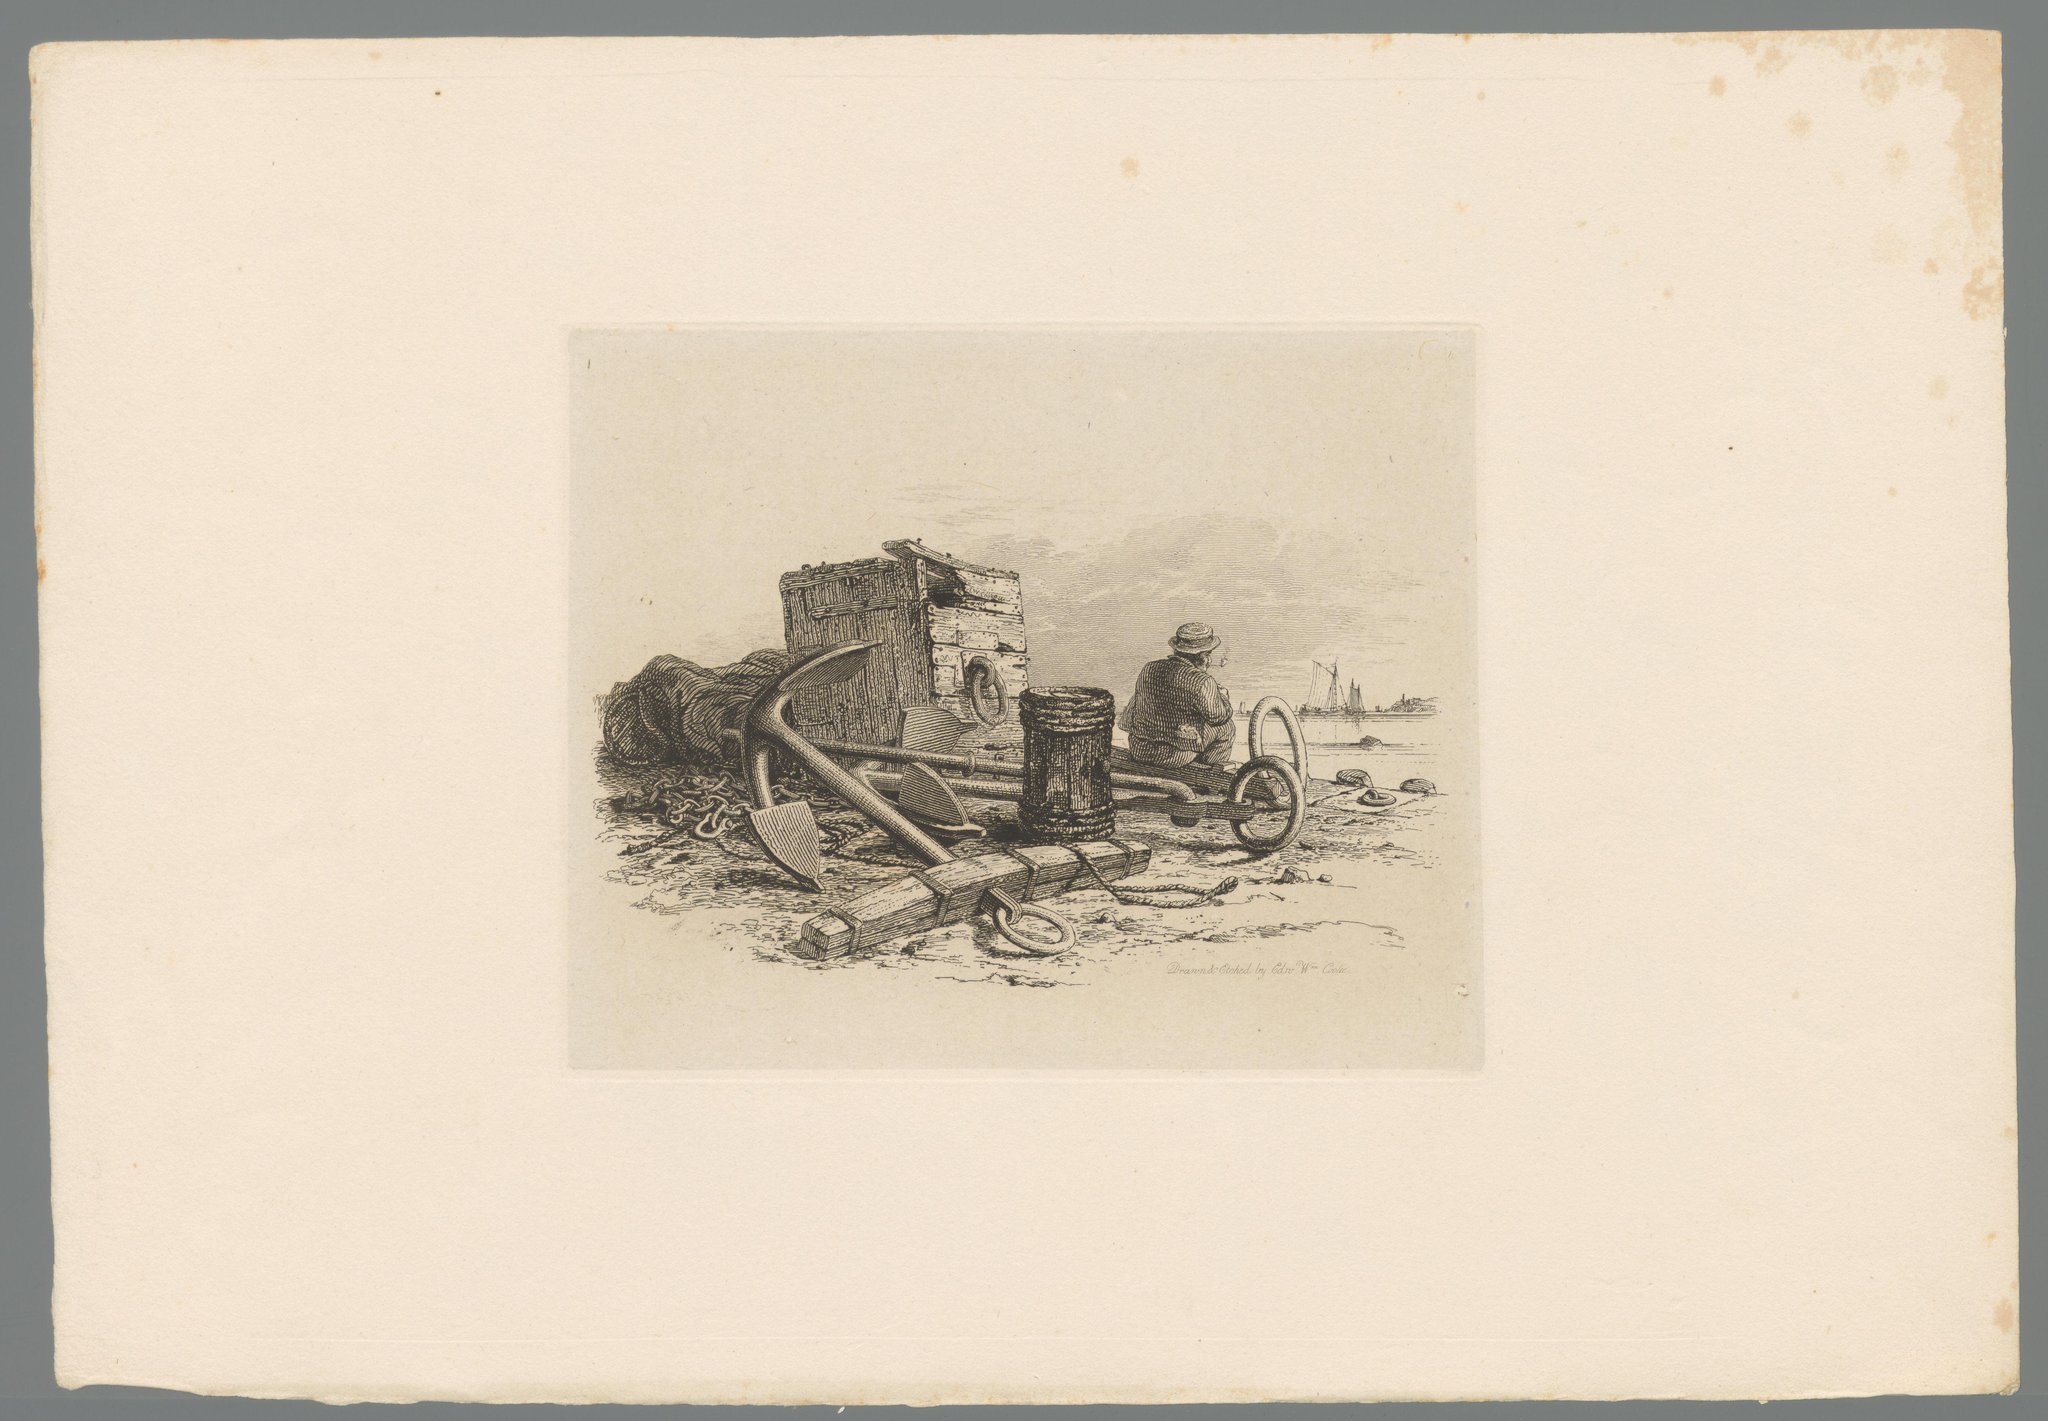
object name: print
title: Anchors & c.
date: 1828-1829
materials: paper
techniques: etching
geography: england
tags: sailing-ship, sailing-boat, fishing net, pipe ~ tobacco, pier, quay, wharf, parts of ship's exterior: anchor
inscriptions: collector's mark: Lugt 2165